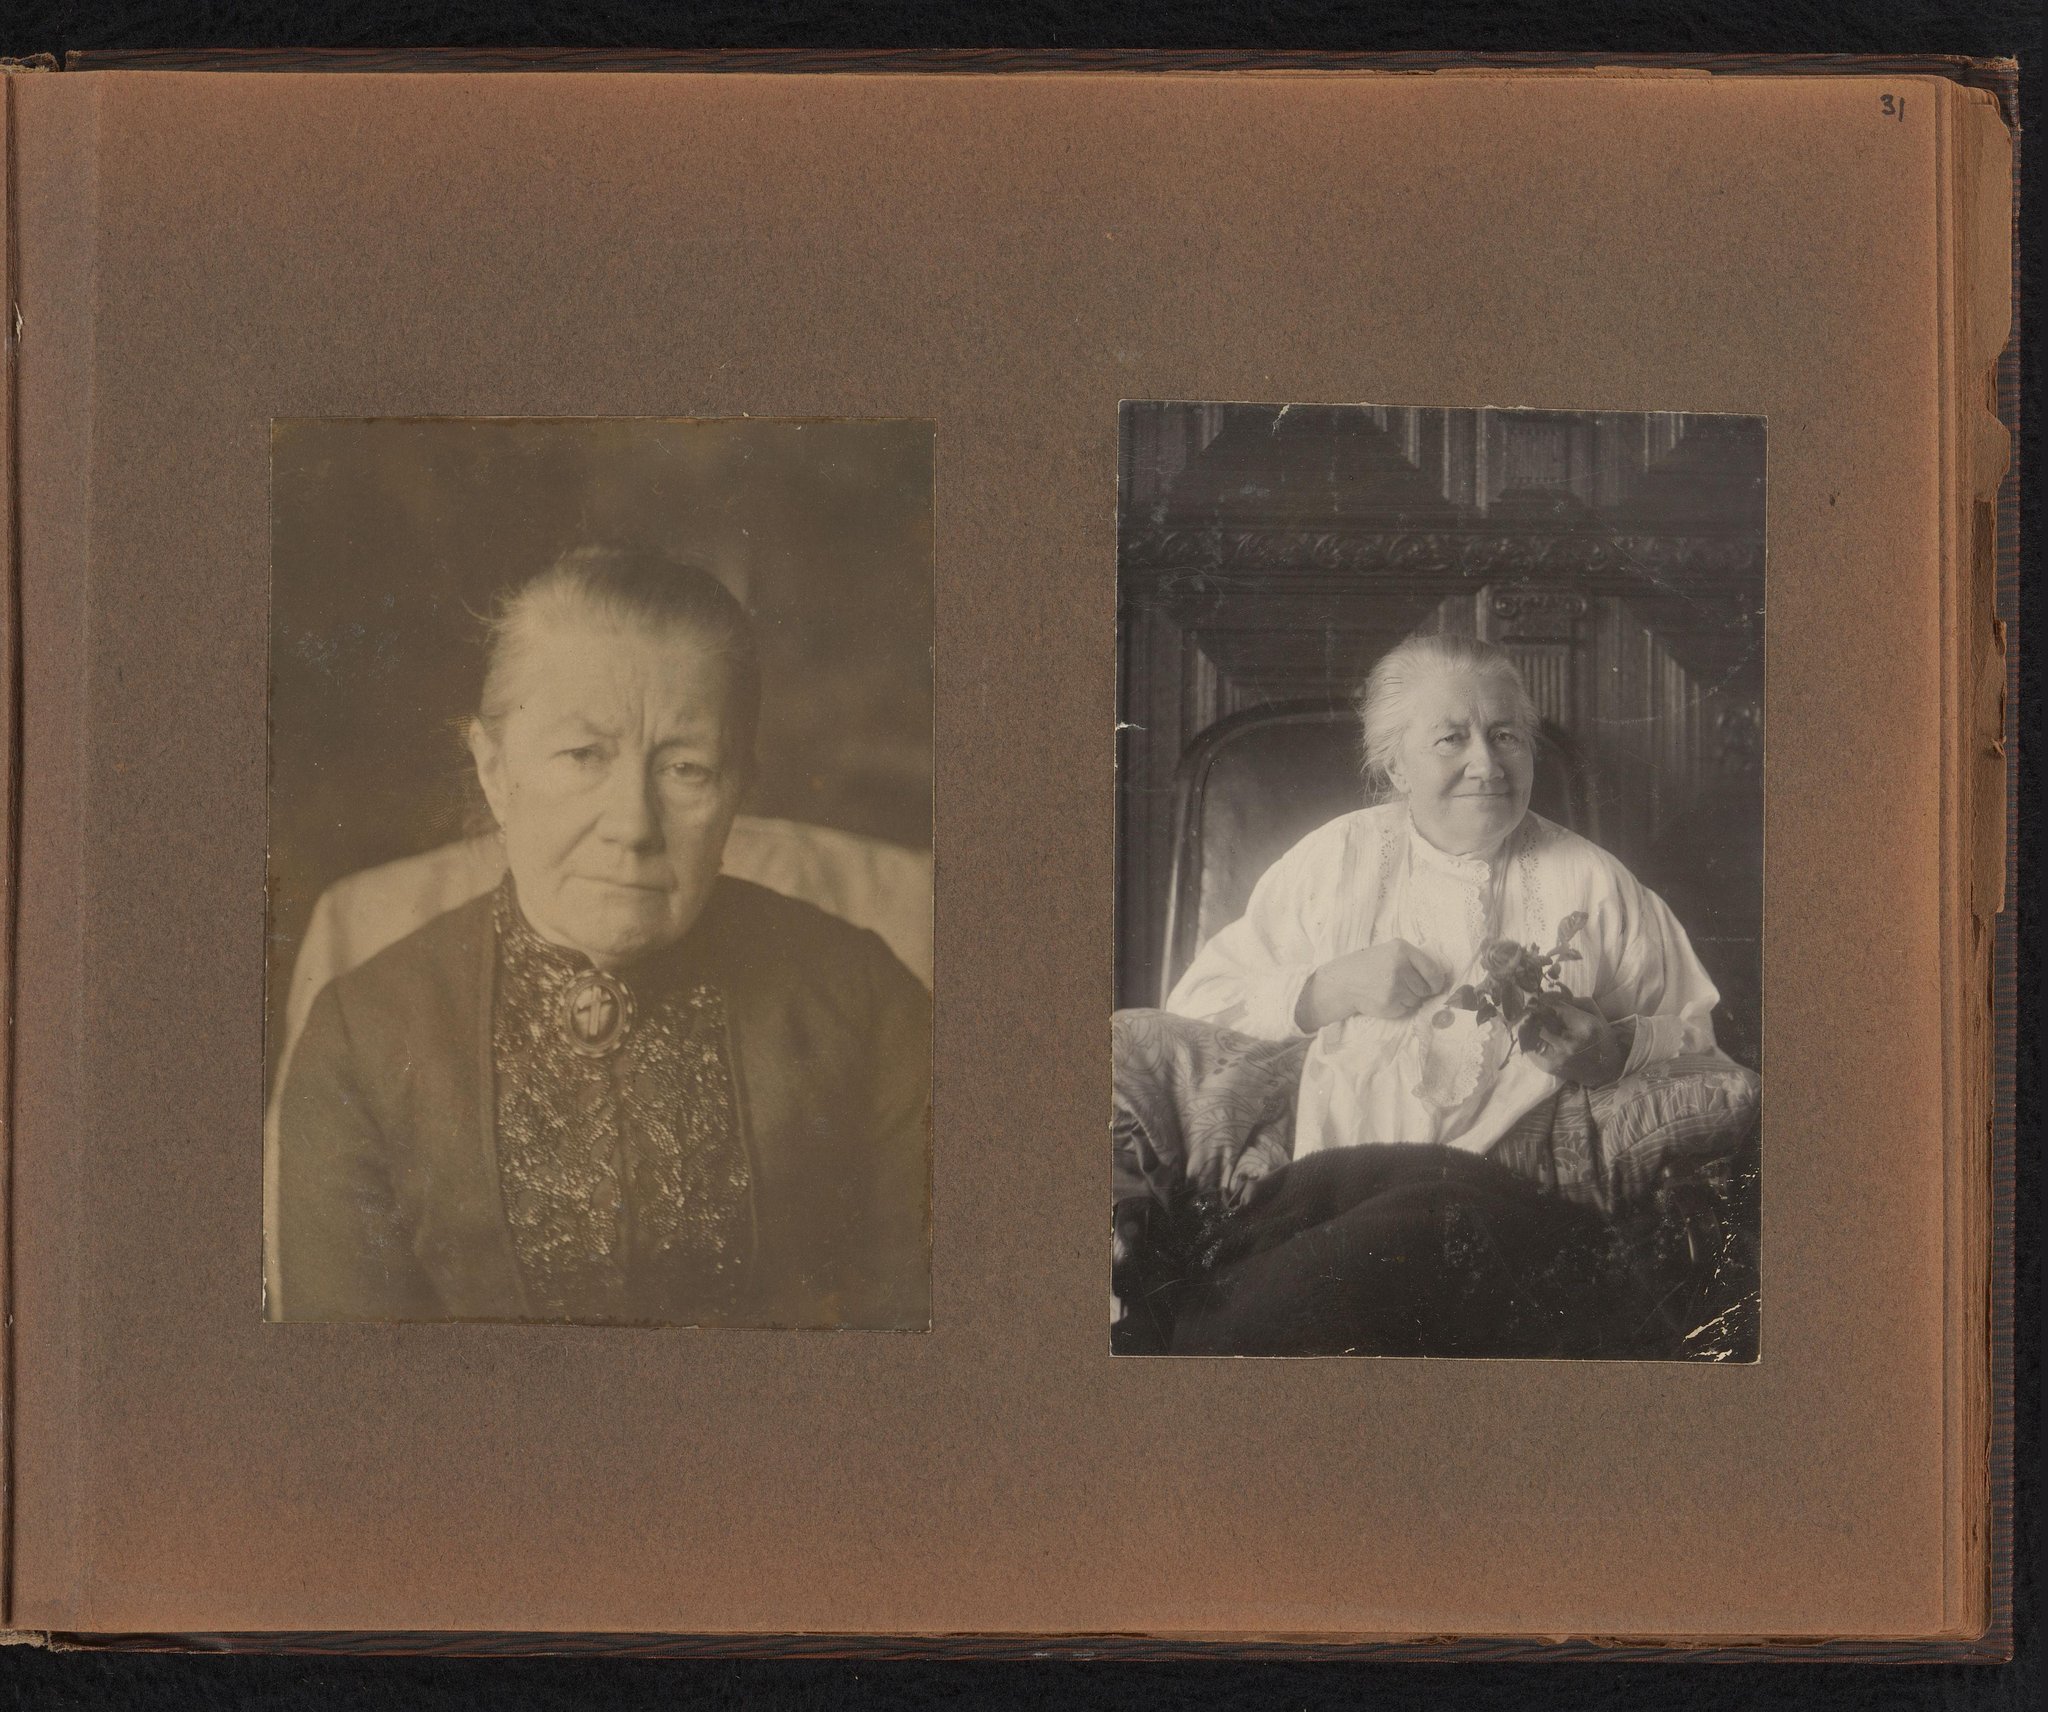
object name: album leaf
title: Bladzijde uit het fotoalbum van de familie Diepenbrock met 2 foto's van Alphons Diepenbrock en zijn omgeving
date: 1870-1920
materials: cardboard, photographic support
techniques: photography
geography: amsterdam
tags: netherlands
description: Bruin albumblad 31 van familiealbum van Alphons Diepenbrock.